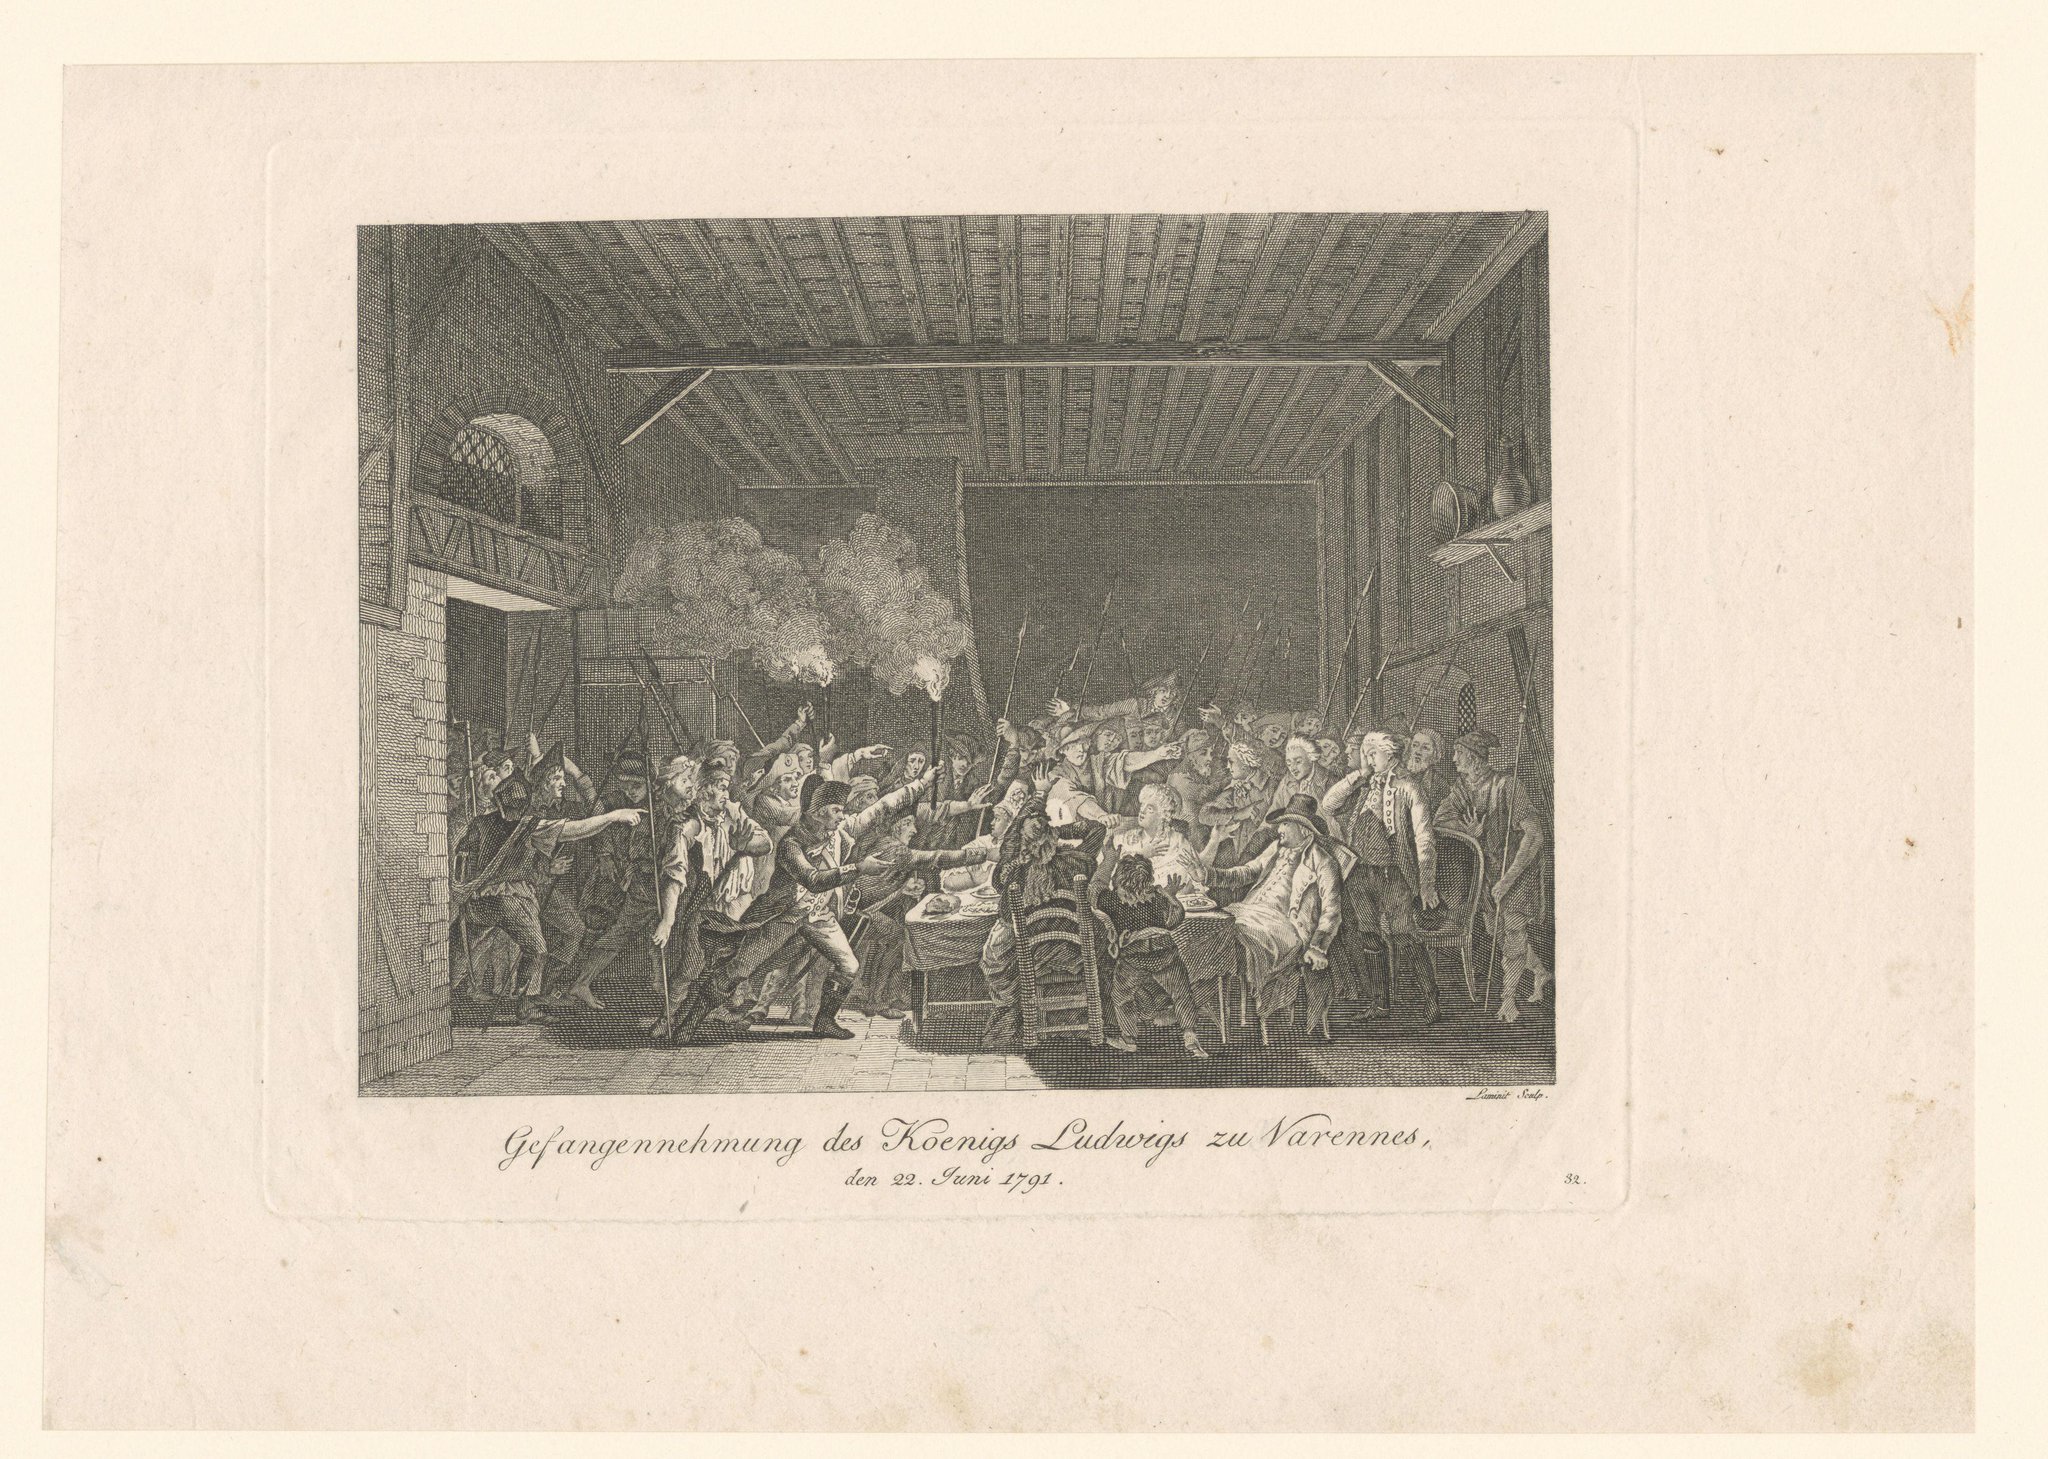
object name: print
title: Gevangenneming van Lodewijk XVI, koning van Frankrijk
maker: paul jacob laminit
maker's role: print maker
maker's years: 1773-1831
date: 1783-1831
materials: paper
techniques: engraving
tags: paris, lodewijk xvi (koning van frankrijk), capture (after revolution) of the old government, surprise attack (stratagem), king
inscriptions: collector's mark: Lugt 2228, collector's mark: Lugt 2760, number: ‘32’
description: Tekst in het Duits in de ondermarge over gevangenneming van Lodewijk XVI op 22 juni 1791.